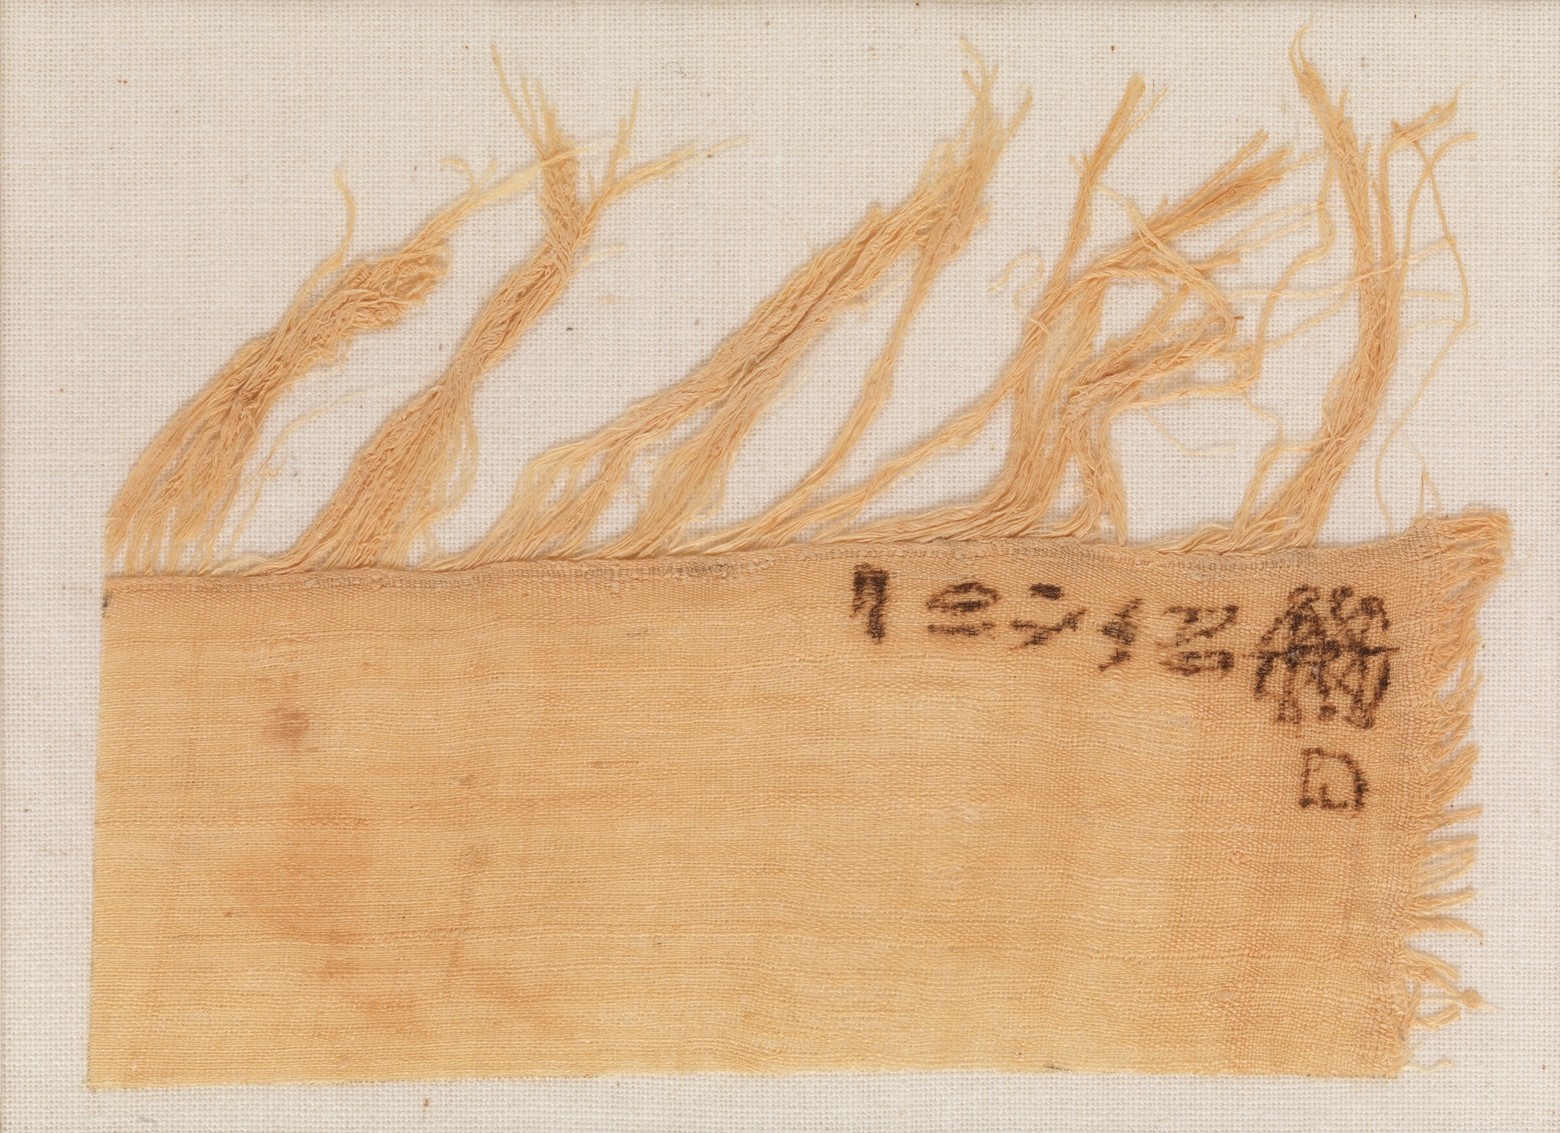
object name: linen mark, wah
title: Linen Mark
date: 1981-1975 BCE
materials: linen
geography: egypt